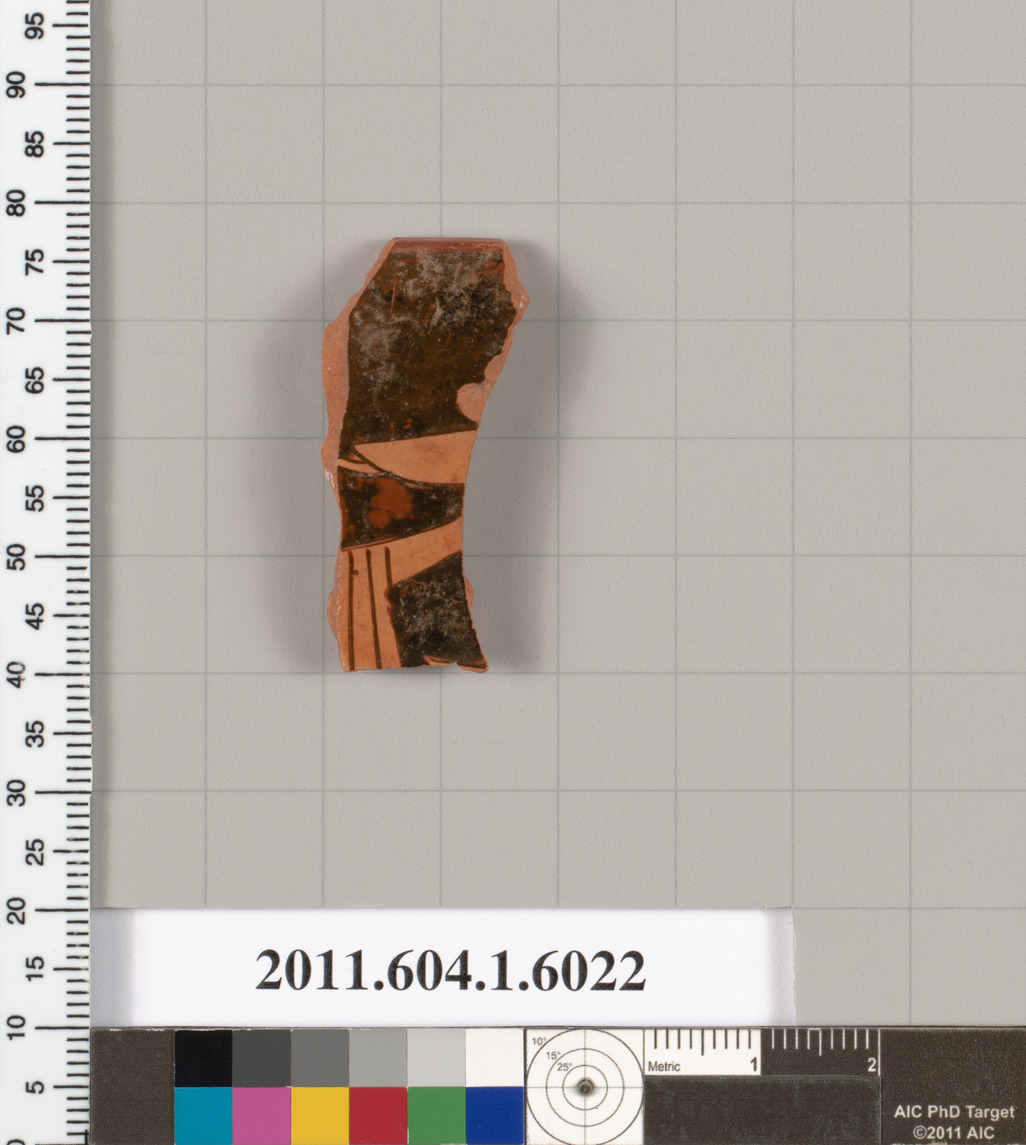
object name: kylix fragment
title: Terracotta rim fragment of a kylix (drinking cup)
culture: greek, attic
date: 510-500 BCE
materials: terracotta